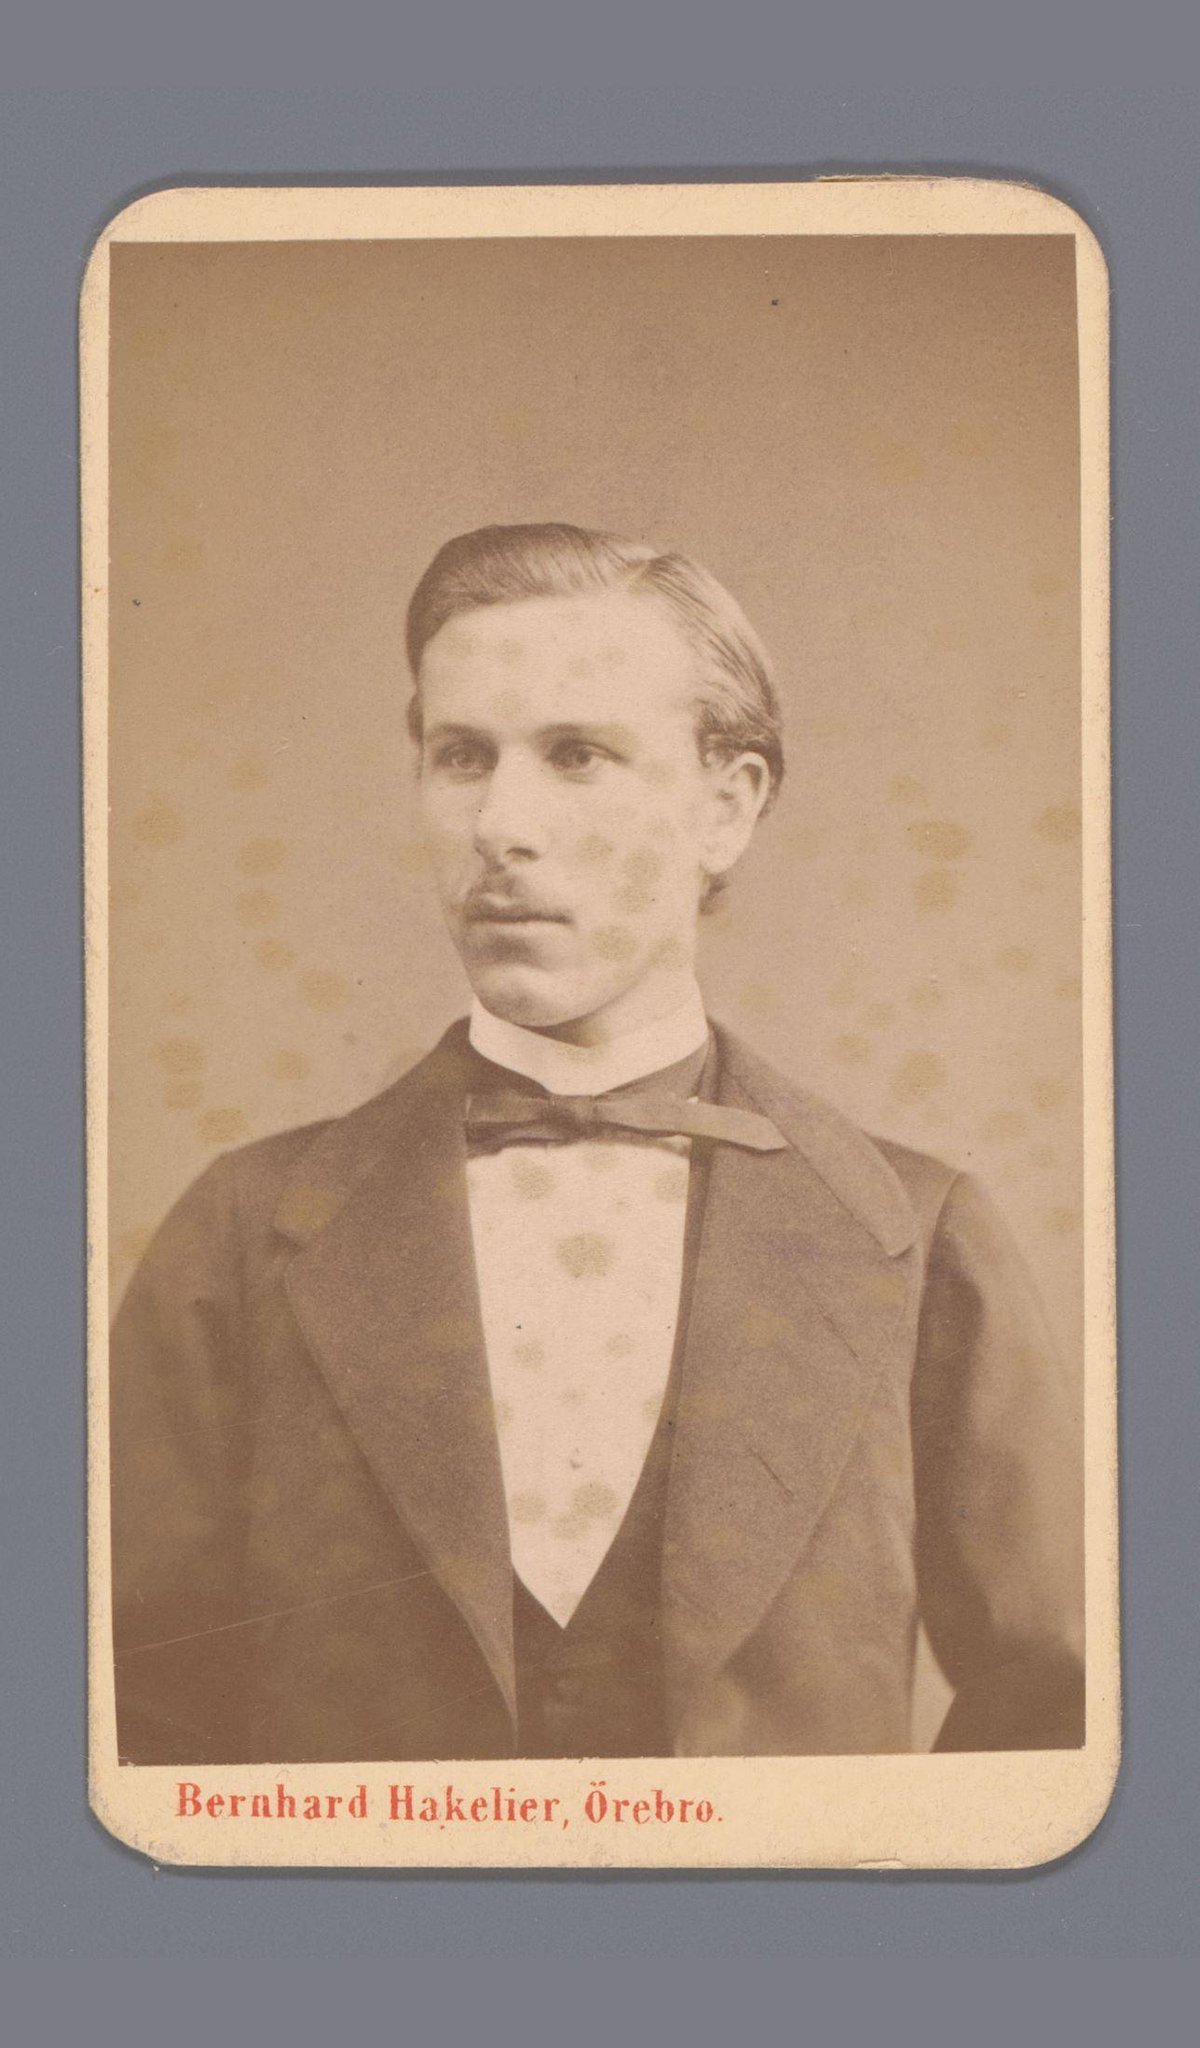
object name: carte de visite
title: Portret van een onbekende jongeman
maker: bernhard hakelier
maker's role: fotograaf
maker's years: 1848-1910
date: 1871-1885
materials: cardboard, paper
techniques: albumen print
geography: orebro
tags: historical persons, youth, adolescent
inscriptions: inscription: ‘FOTOGRAFI/ af/ Bernhard Hakelier./ ÖREBRO/ 21. Köpmangatan 21./ Större antal af samma sort kan erhållas om Requisi-/tion insändes till Ateliern./ A larger number of the same sort can be had on/ application to Mr Hakelier 21 Mechant street Örebro.’